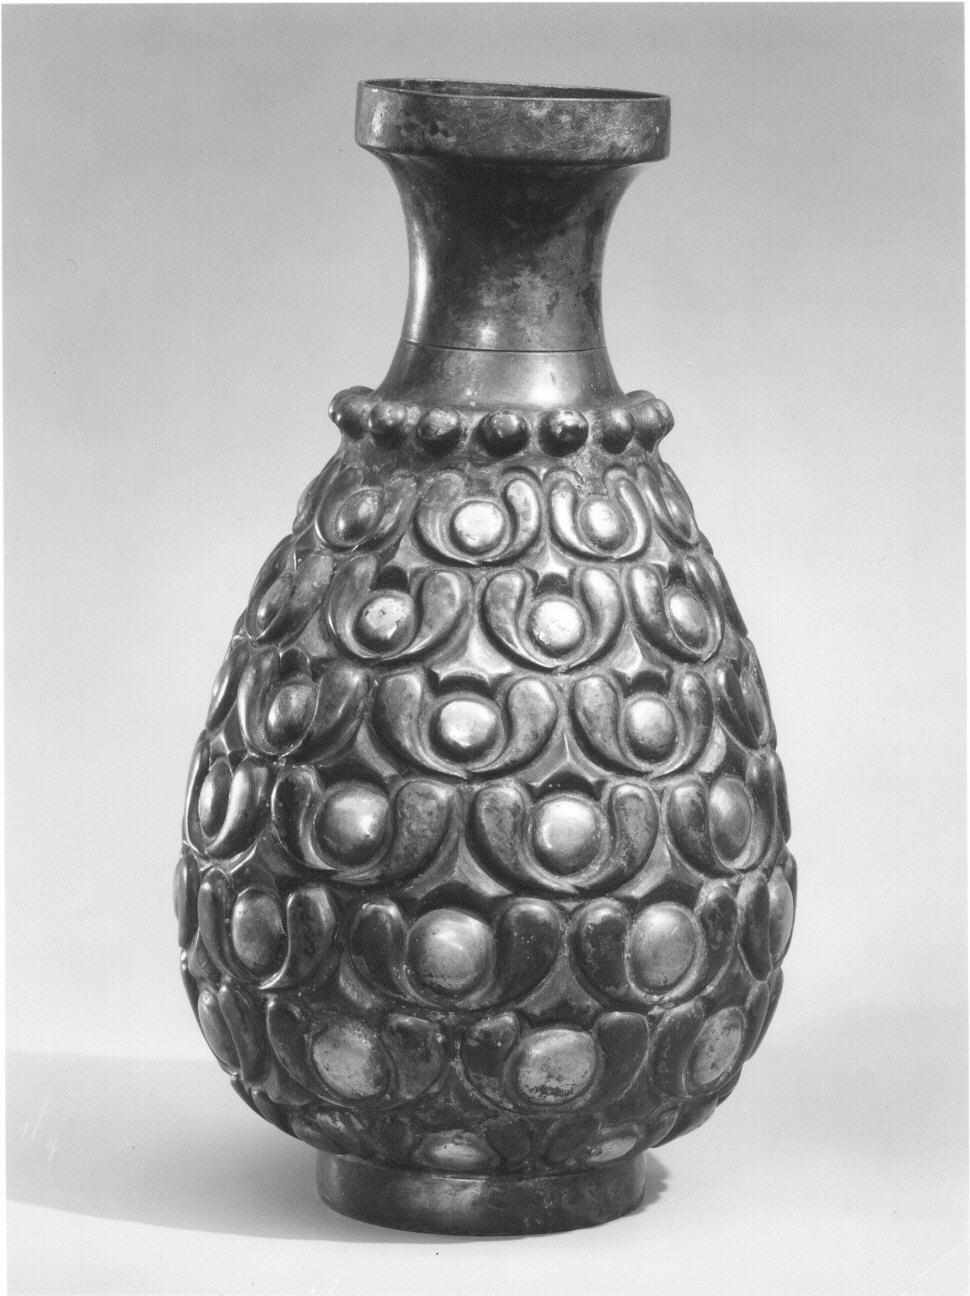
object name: vase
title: Pear-Shaped Vase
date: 701-800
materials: silver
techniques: gilding, hammering, repoussé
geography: iran